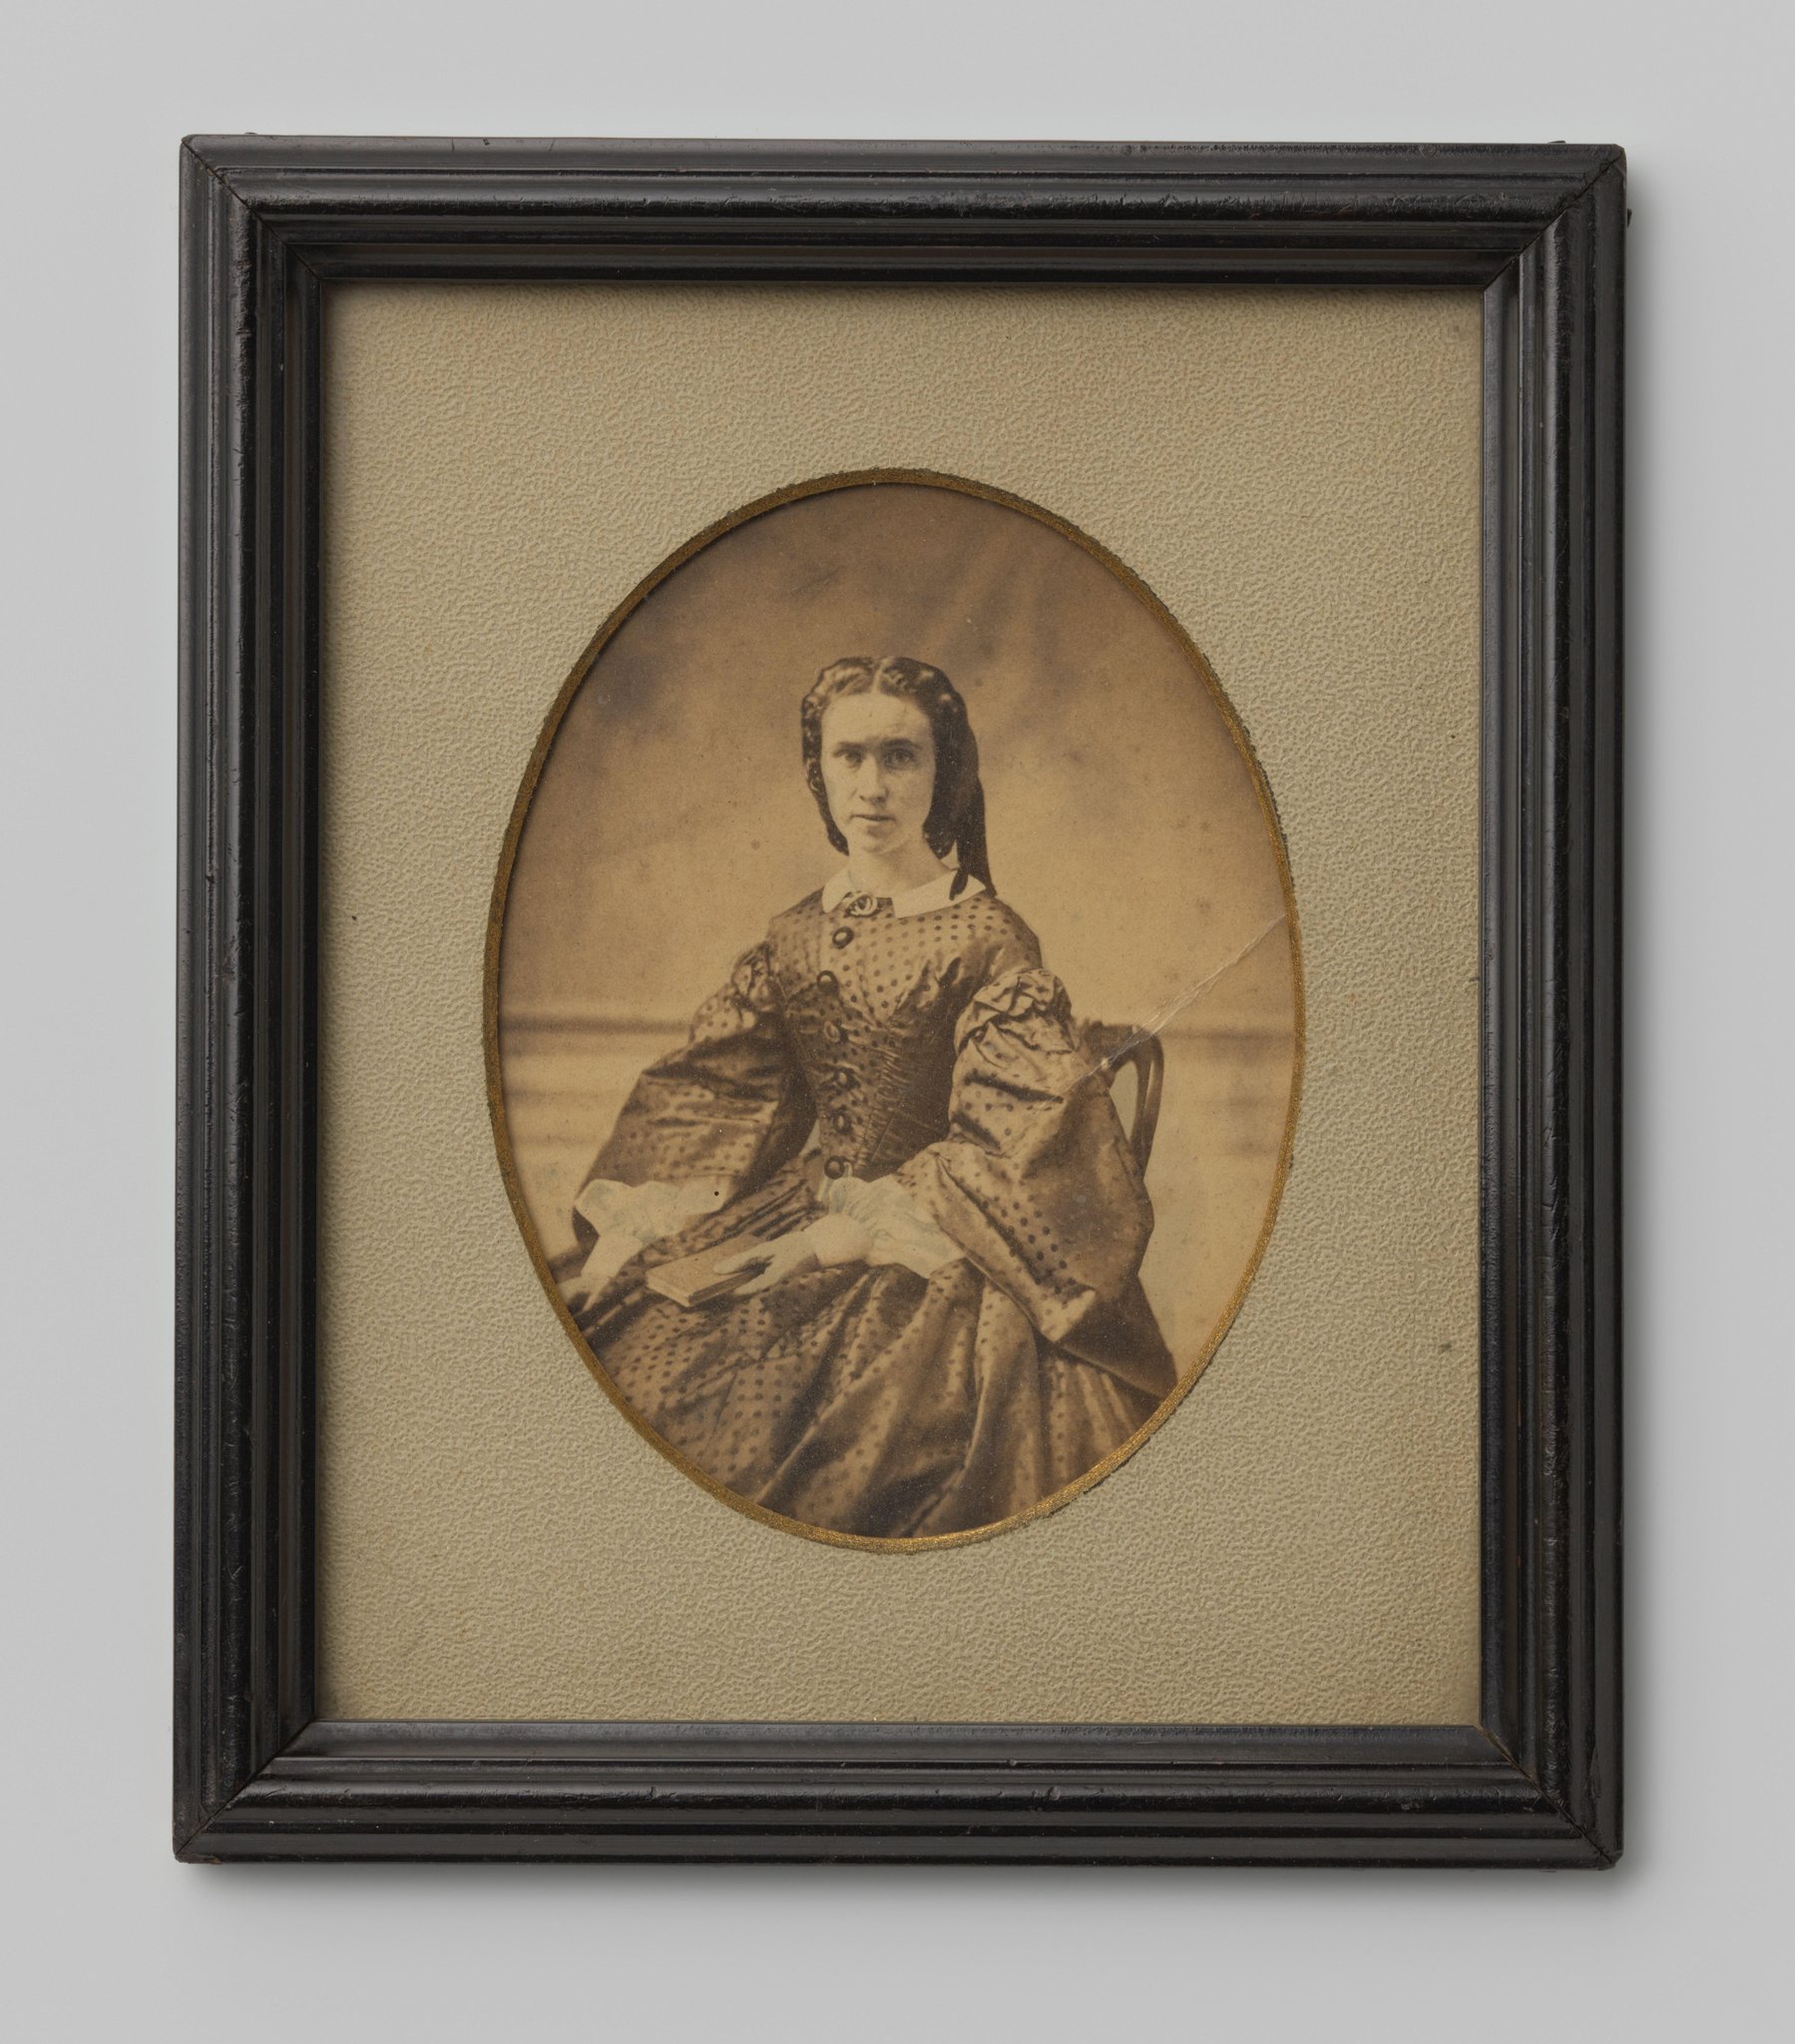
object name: frame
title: Portret van een onbekende vrouw met een boek in haar hand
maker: Anonymous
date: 1880-1900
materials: cardboard, glass, metal, paper, wood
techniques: albumen print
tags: book, anonymous historical person portrayed - bb - woman